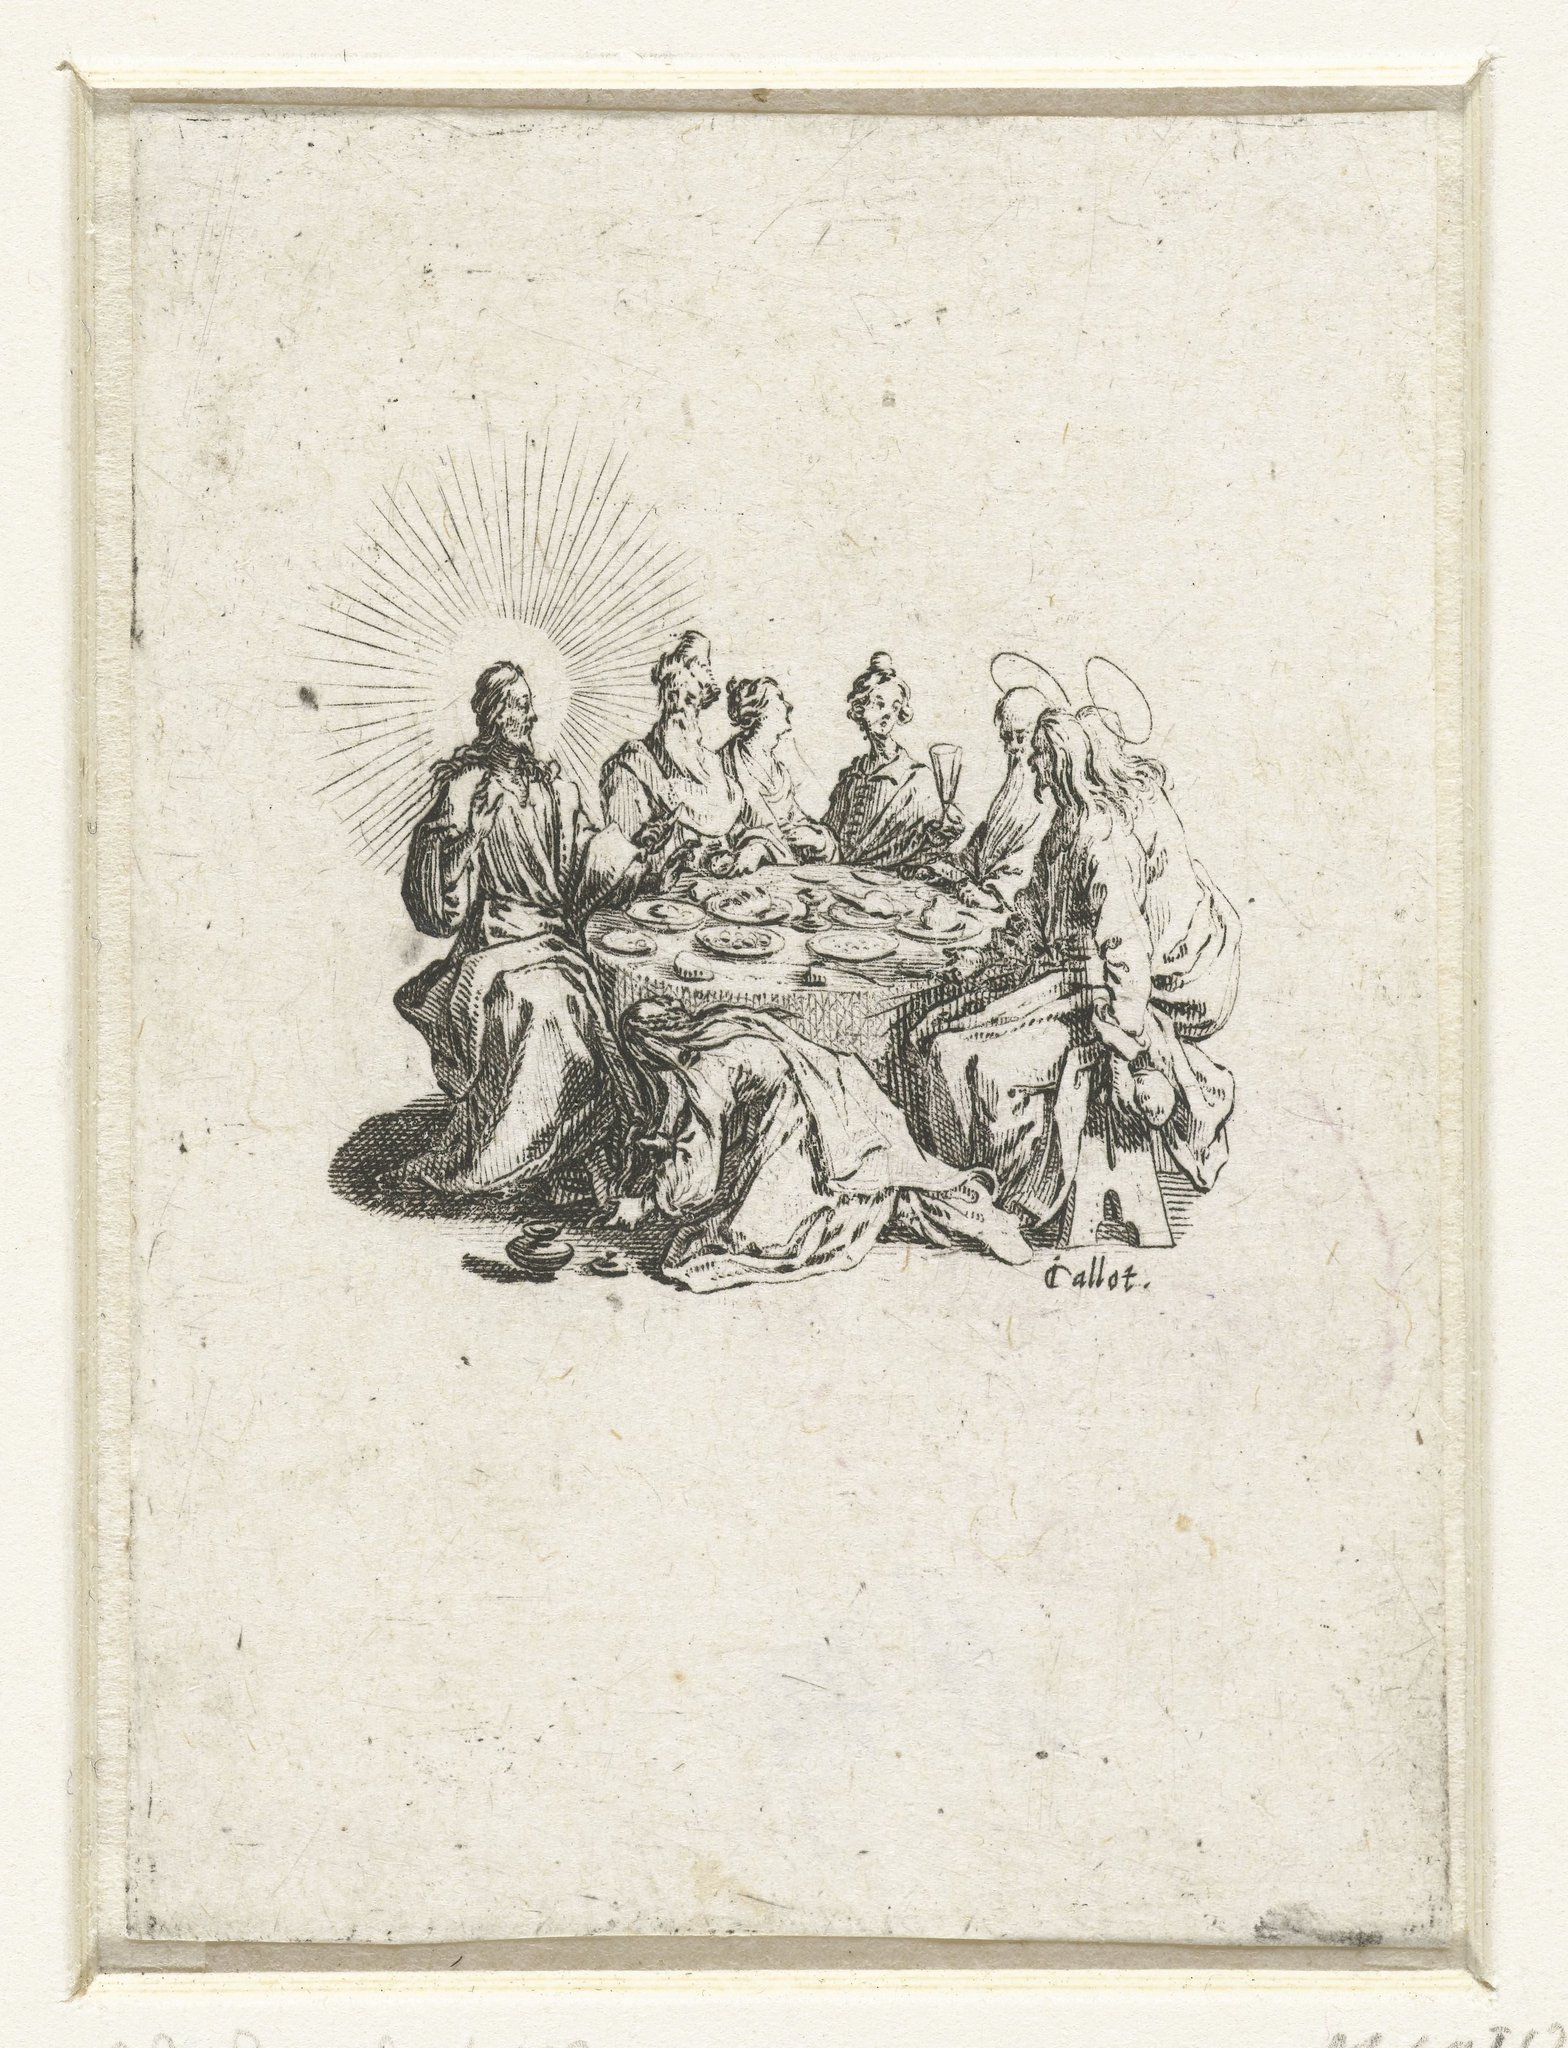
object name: print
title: Maaltijd bij Simon de farizeeër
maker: jacques callot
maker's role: draughtsman, print maker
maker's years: 1592-1635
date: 1621-1625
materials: paper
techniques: engraving, etching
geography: nancy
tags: a woman washes christ's feet with her tears, and wipes them with her hair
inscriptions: collector's mark: Lugt 240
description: Een vrouw (Maria Magdalena) zalft de voeten van Christus, terwijl hij aan een ronde tafel zit met een farizeeër (Simon), twee dames en enkele discipelen. Deze prent is onderdeel van een vierdelige serie prenten met maaltijden waaraan Christus deelneemt.